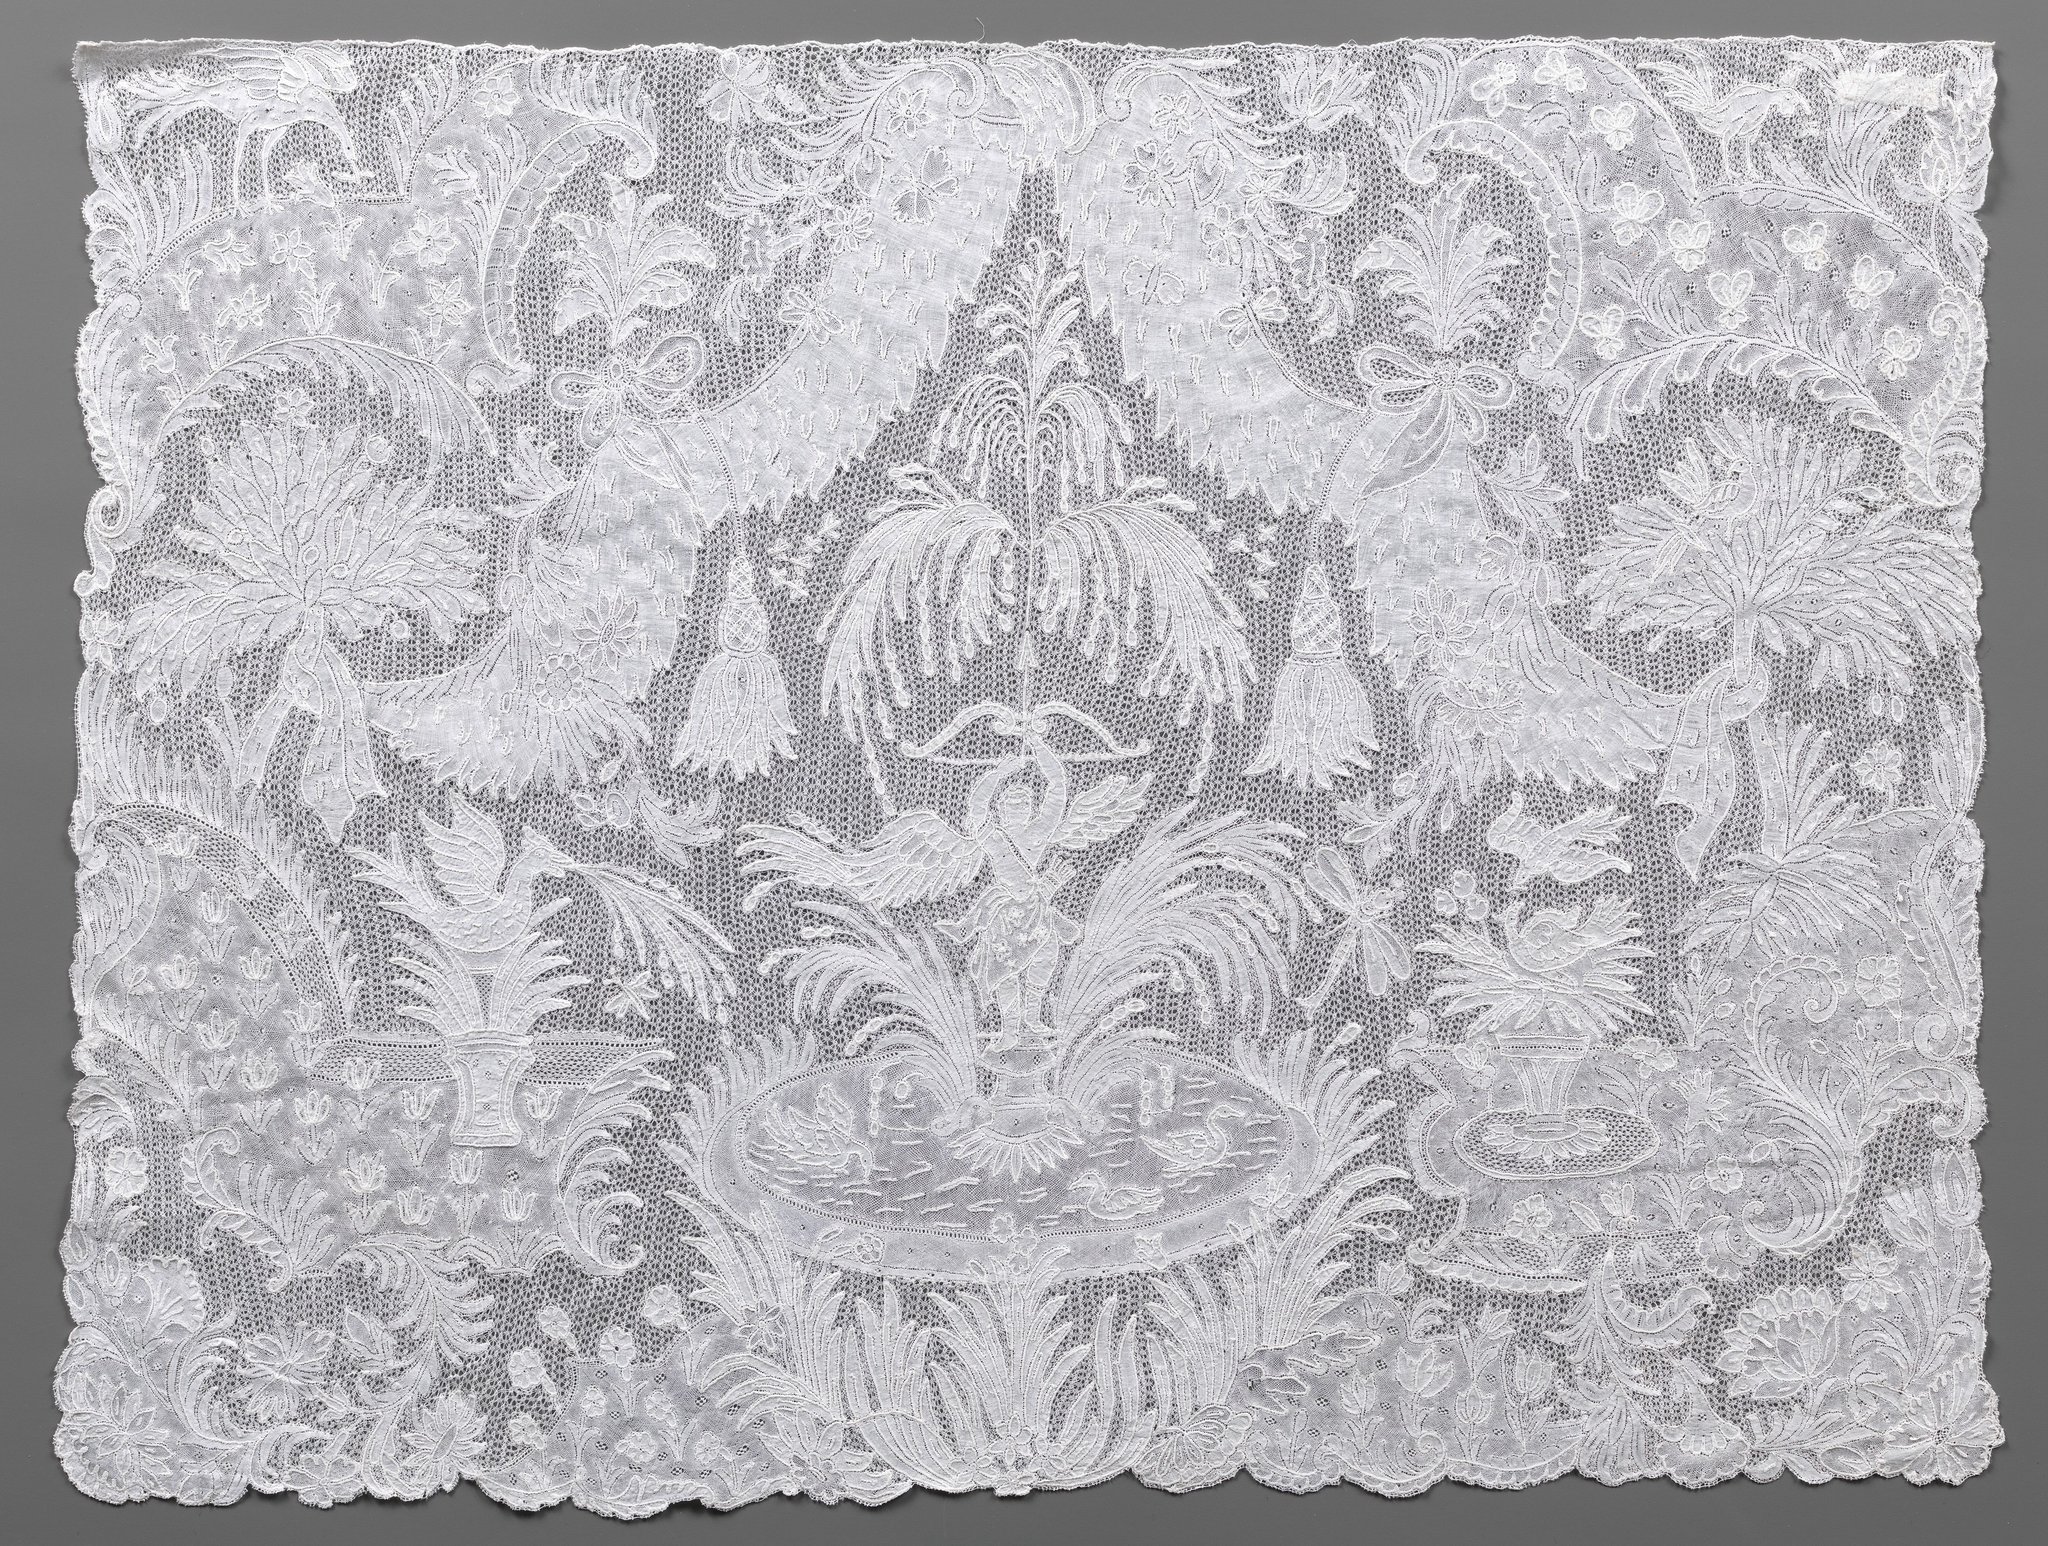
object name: cravat end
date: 1734-1766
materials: linen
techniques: lace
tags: birds,fountains,cupid